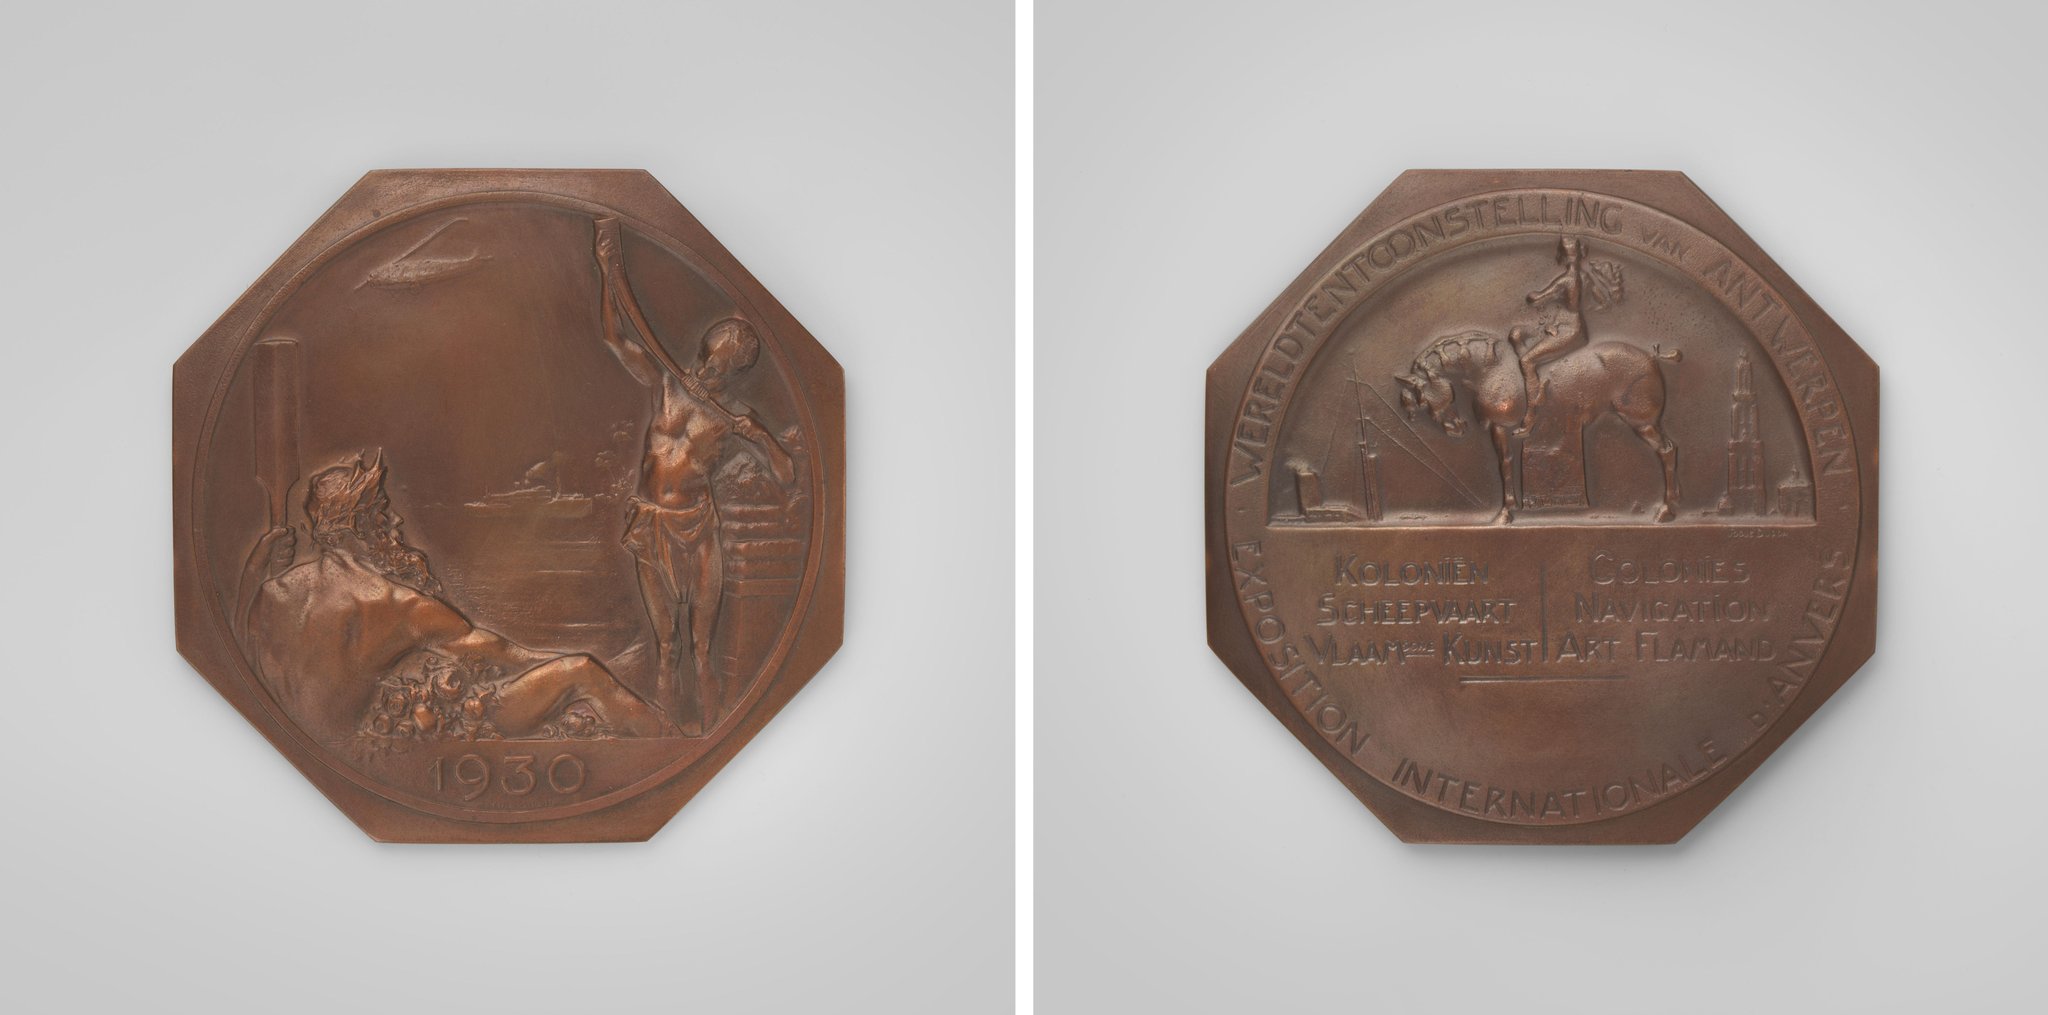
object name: history medal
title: Vijfentwintigjarig regeringsjubileum van Koning Leopold I van België 1856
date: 1856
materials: copper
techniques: striking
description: Verguld koperen penning, op de voorzijde een tronende vrouw naar links met scepter, houdt een krans en een palmtak boven een versierd standbeeld van Leopold, met afsnedetekst, op de keerzijde vijf regels tekst tussen samengestrikte lauwertakken.